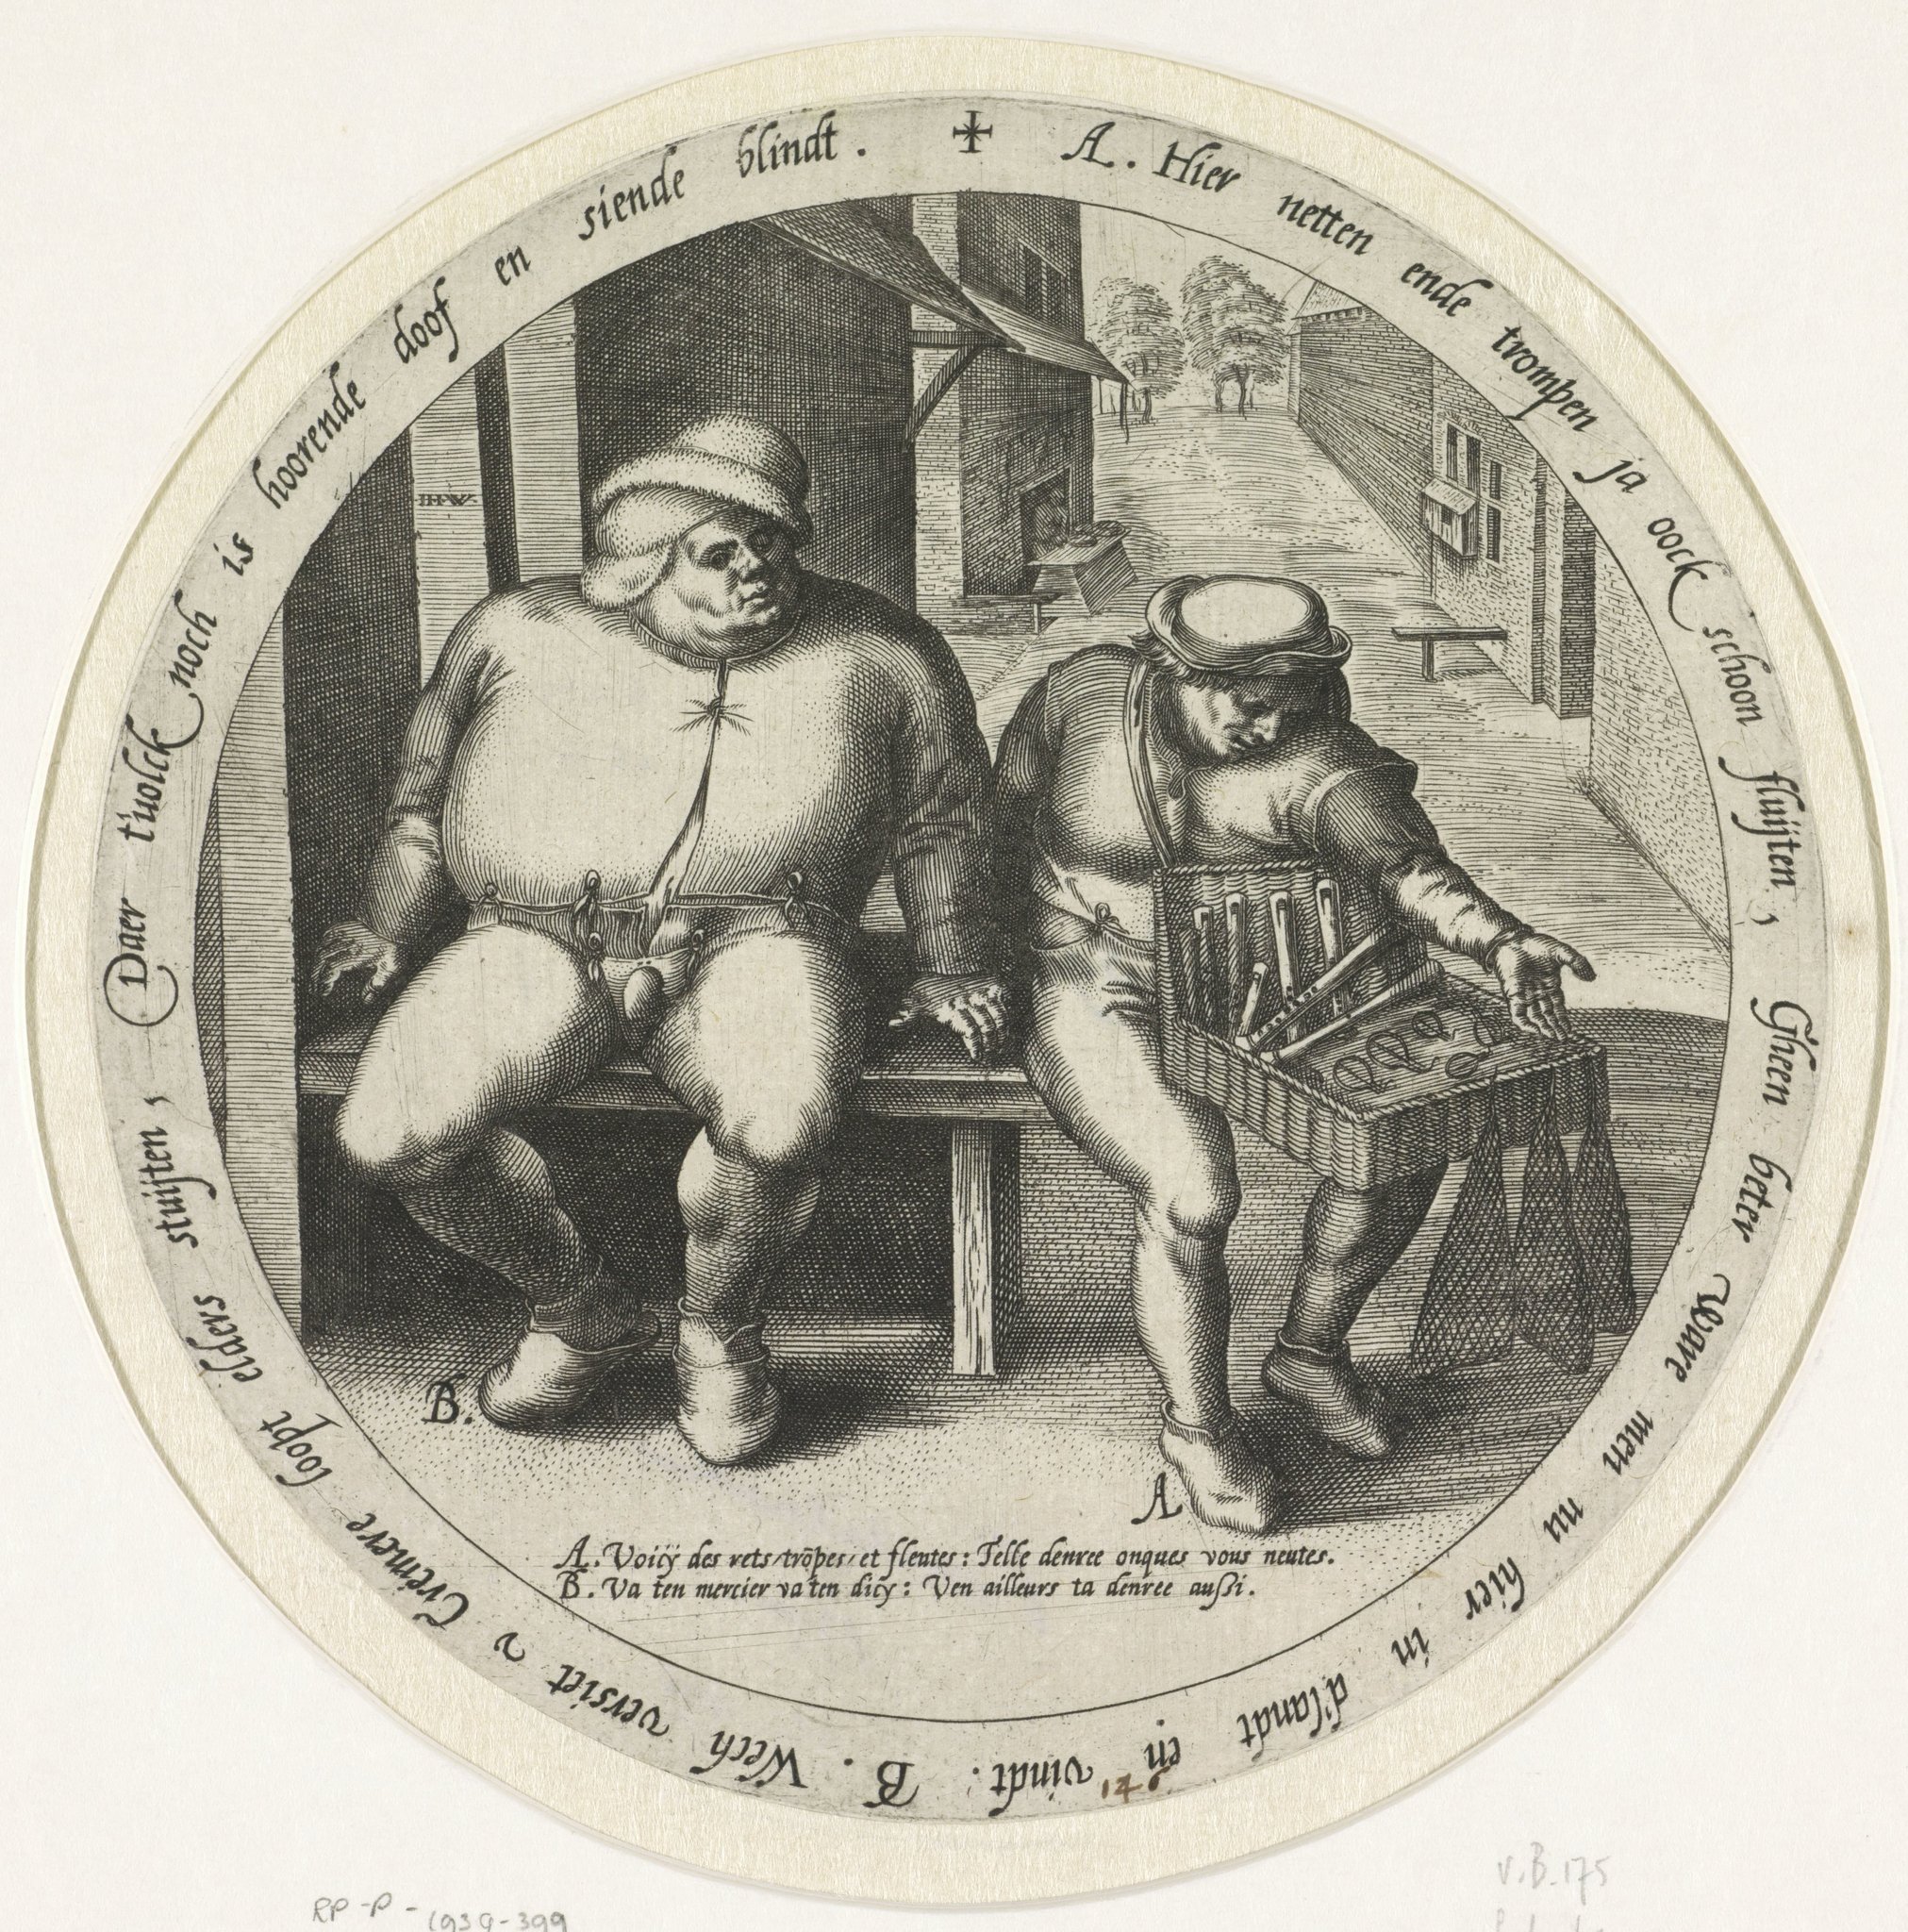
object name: print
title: Vlaamse spreekwoorden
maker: johannes wierix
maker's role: draughtsman, print maker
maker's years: 1549-1618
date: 1566-1570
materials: paper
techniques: engraving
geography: antwerp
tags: fat (human type), pedlar, proverbs, sayings, etc.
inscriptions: collector's mark: Lugt 2228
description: Een marskramer toont zijn koopwaren aan een dikke man die naast hem op een bank zit. In het randschrift een toelichting op de voorstelling en op het spreekwoord in het Nederlands.